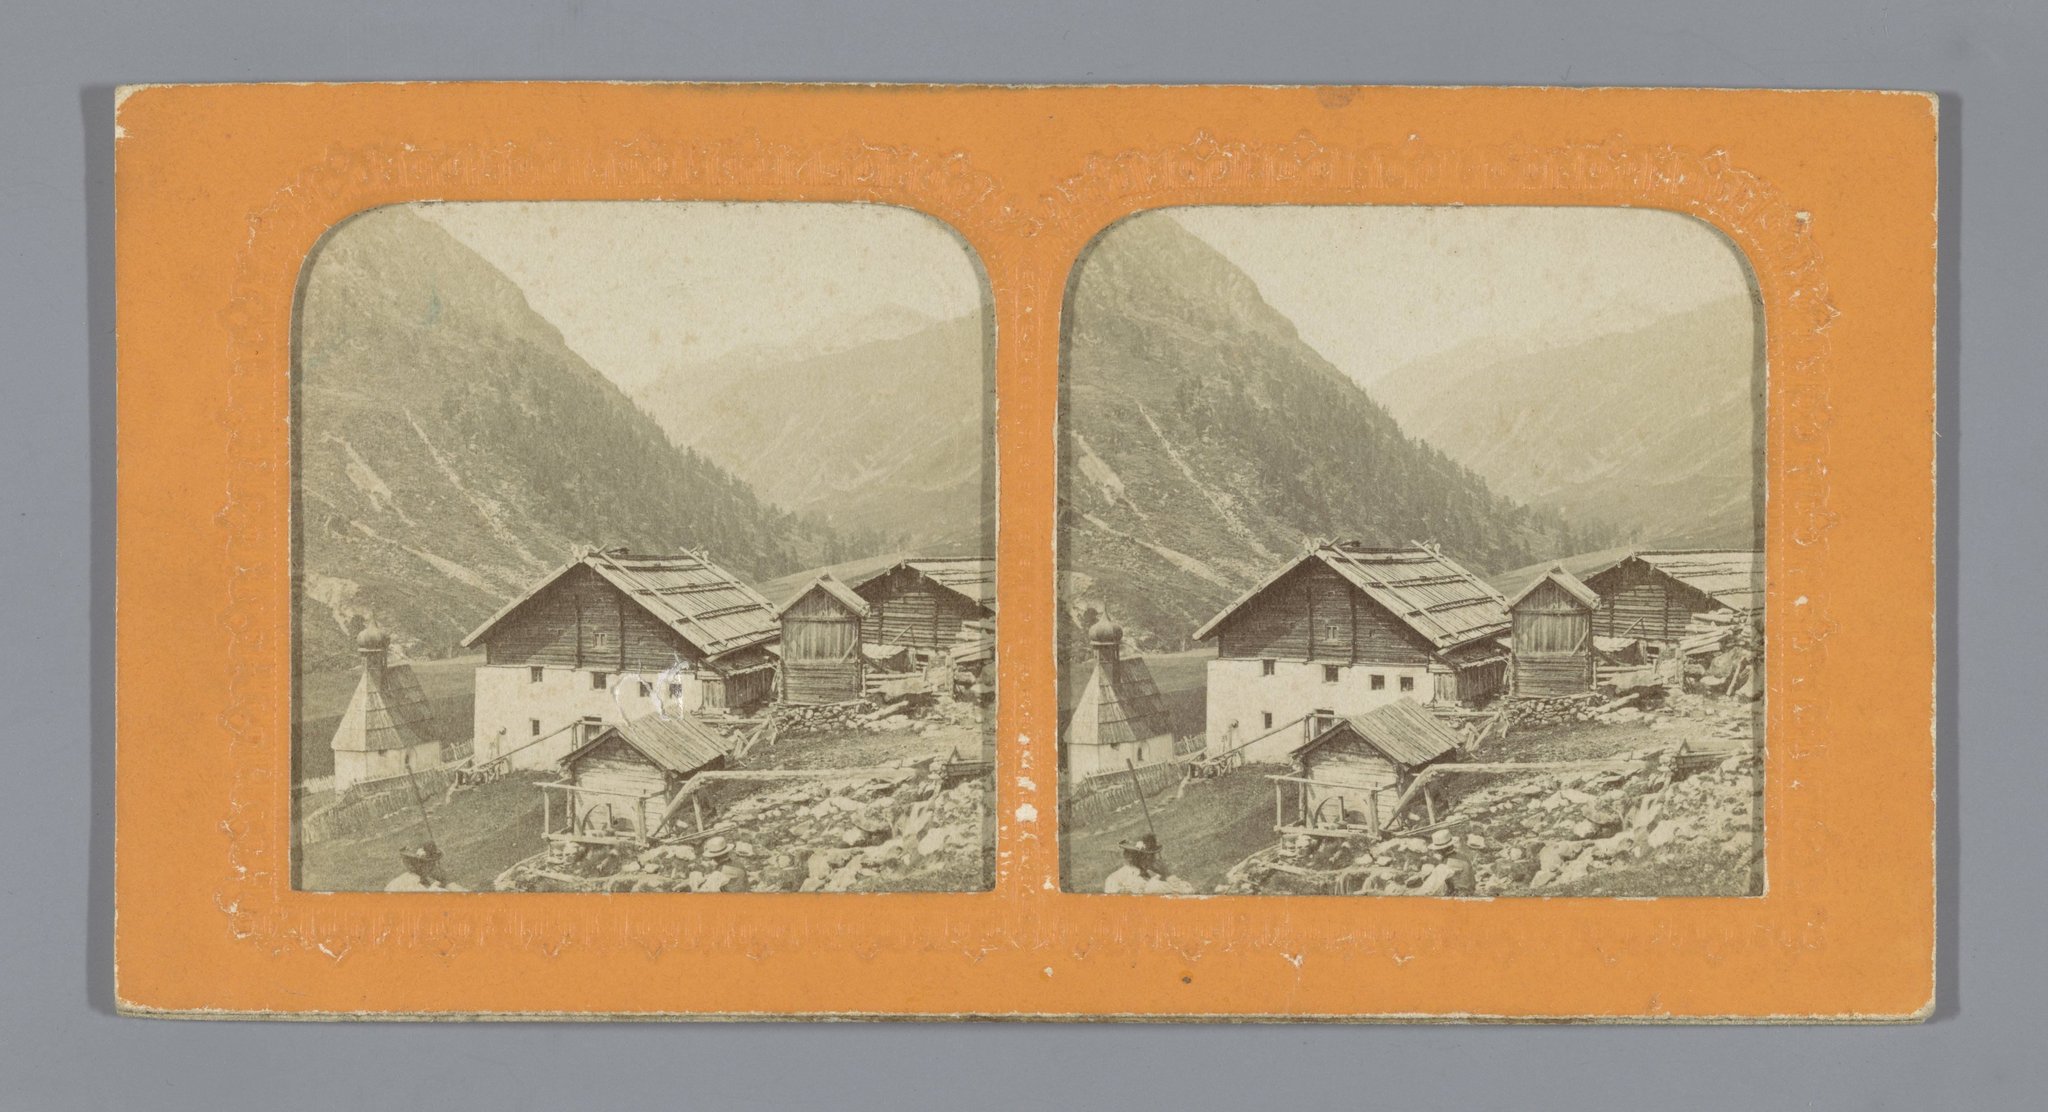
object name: tissue stereograph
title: Fend, Tyrol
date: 1855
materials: cardboard, paper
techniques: albumen print, hand coloring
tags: village, mountains